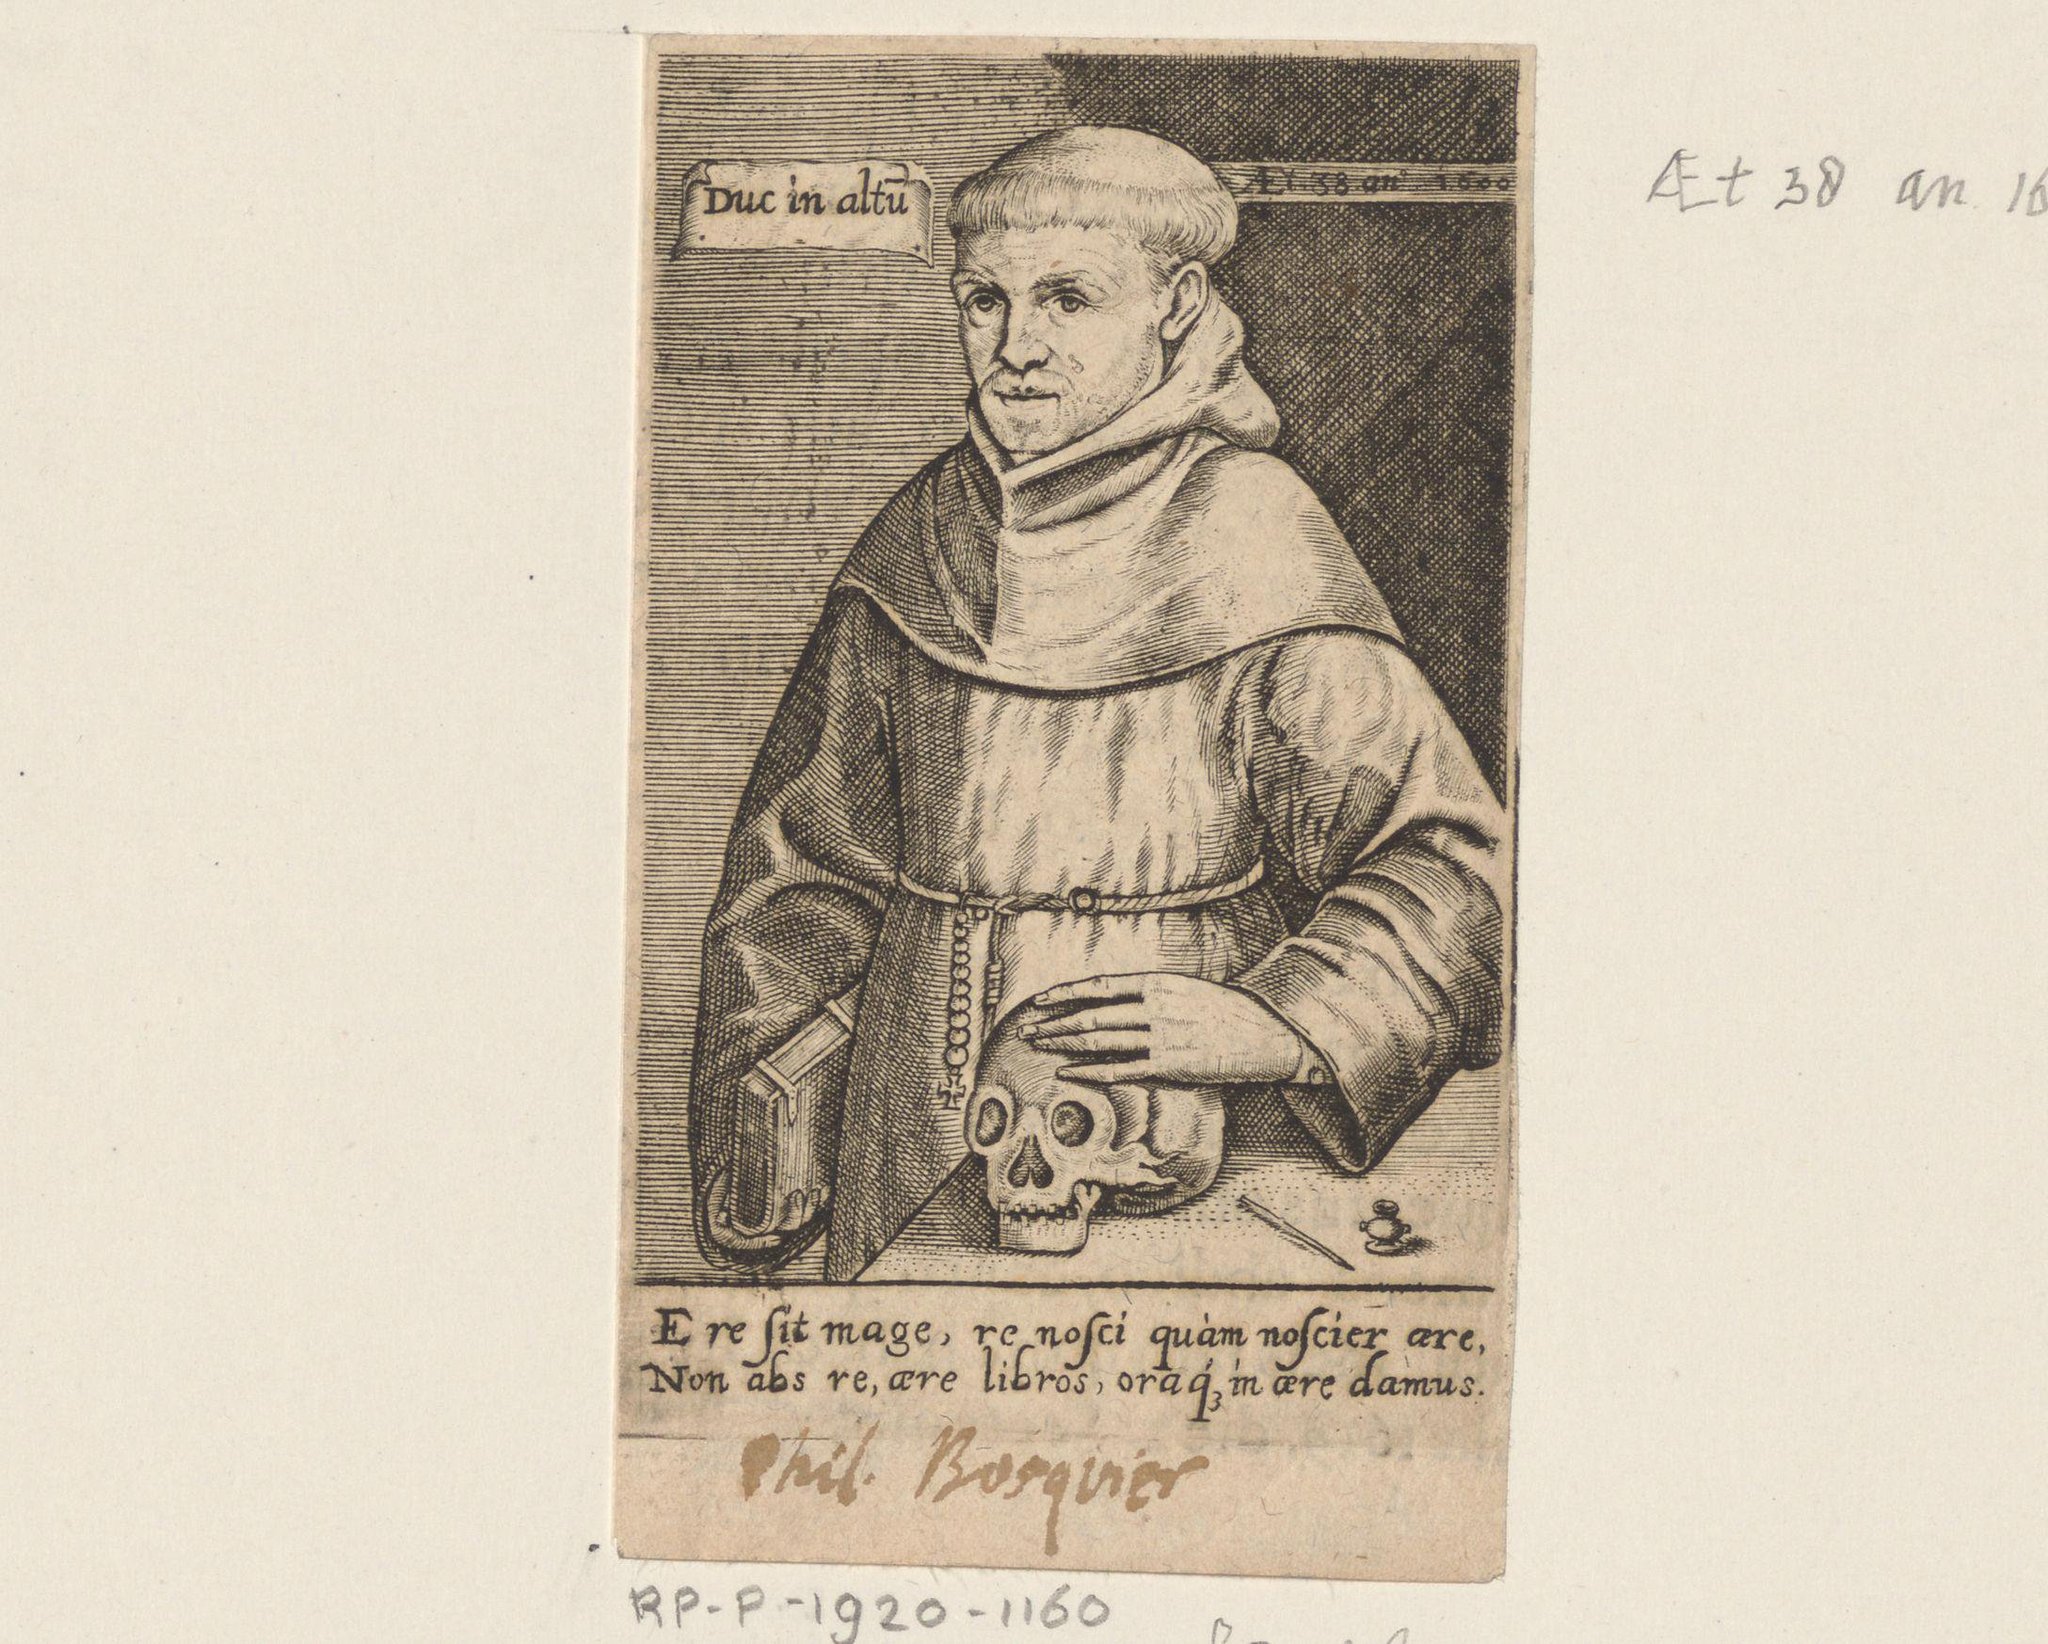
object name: print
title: Portret van Philippe Bosquier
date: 1625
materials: paper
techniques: engraving, letterpress printing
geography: cologne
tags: historical persons, monk(s), friar(s), death's head, skull (symbol of death)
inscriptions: collector's mark: Lugt 2228, inscription: ‘Phil. Bosquier’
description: Prent uit: Bosquier, Philippe. Scipio claudicantium, seu, catechismi (...). Keulen: Peter Henning, 1625.